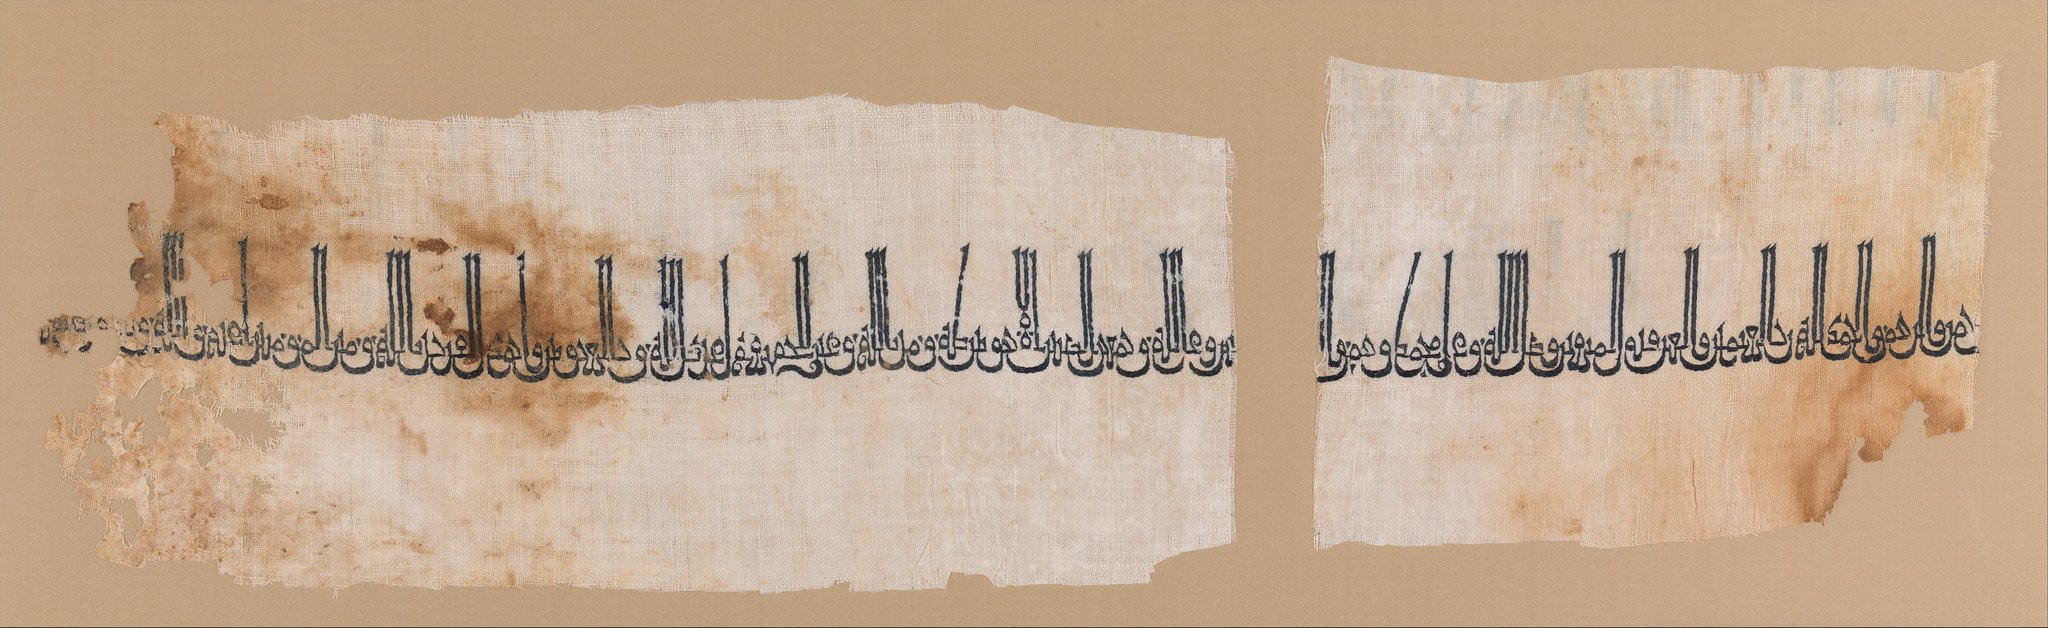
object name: textile fragment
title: Tiraz Textile Fragment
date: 991-1031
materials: linen, silk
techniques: embroidery, weave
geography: iraq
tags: arabic